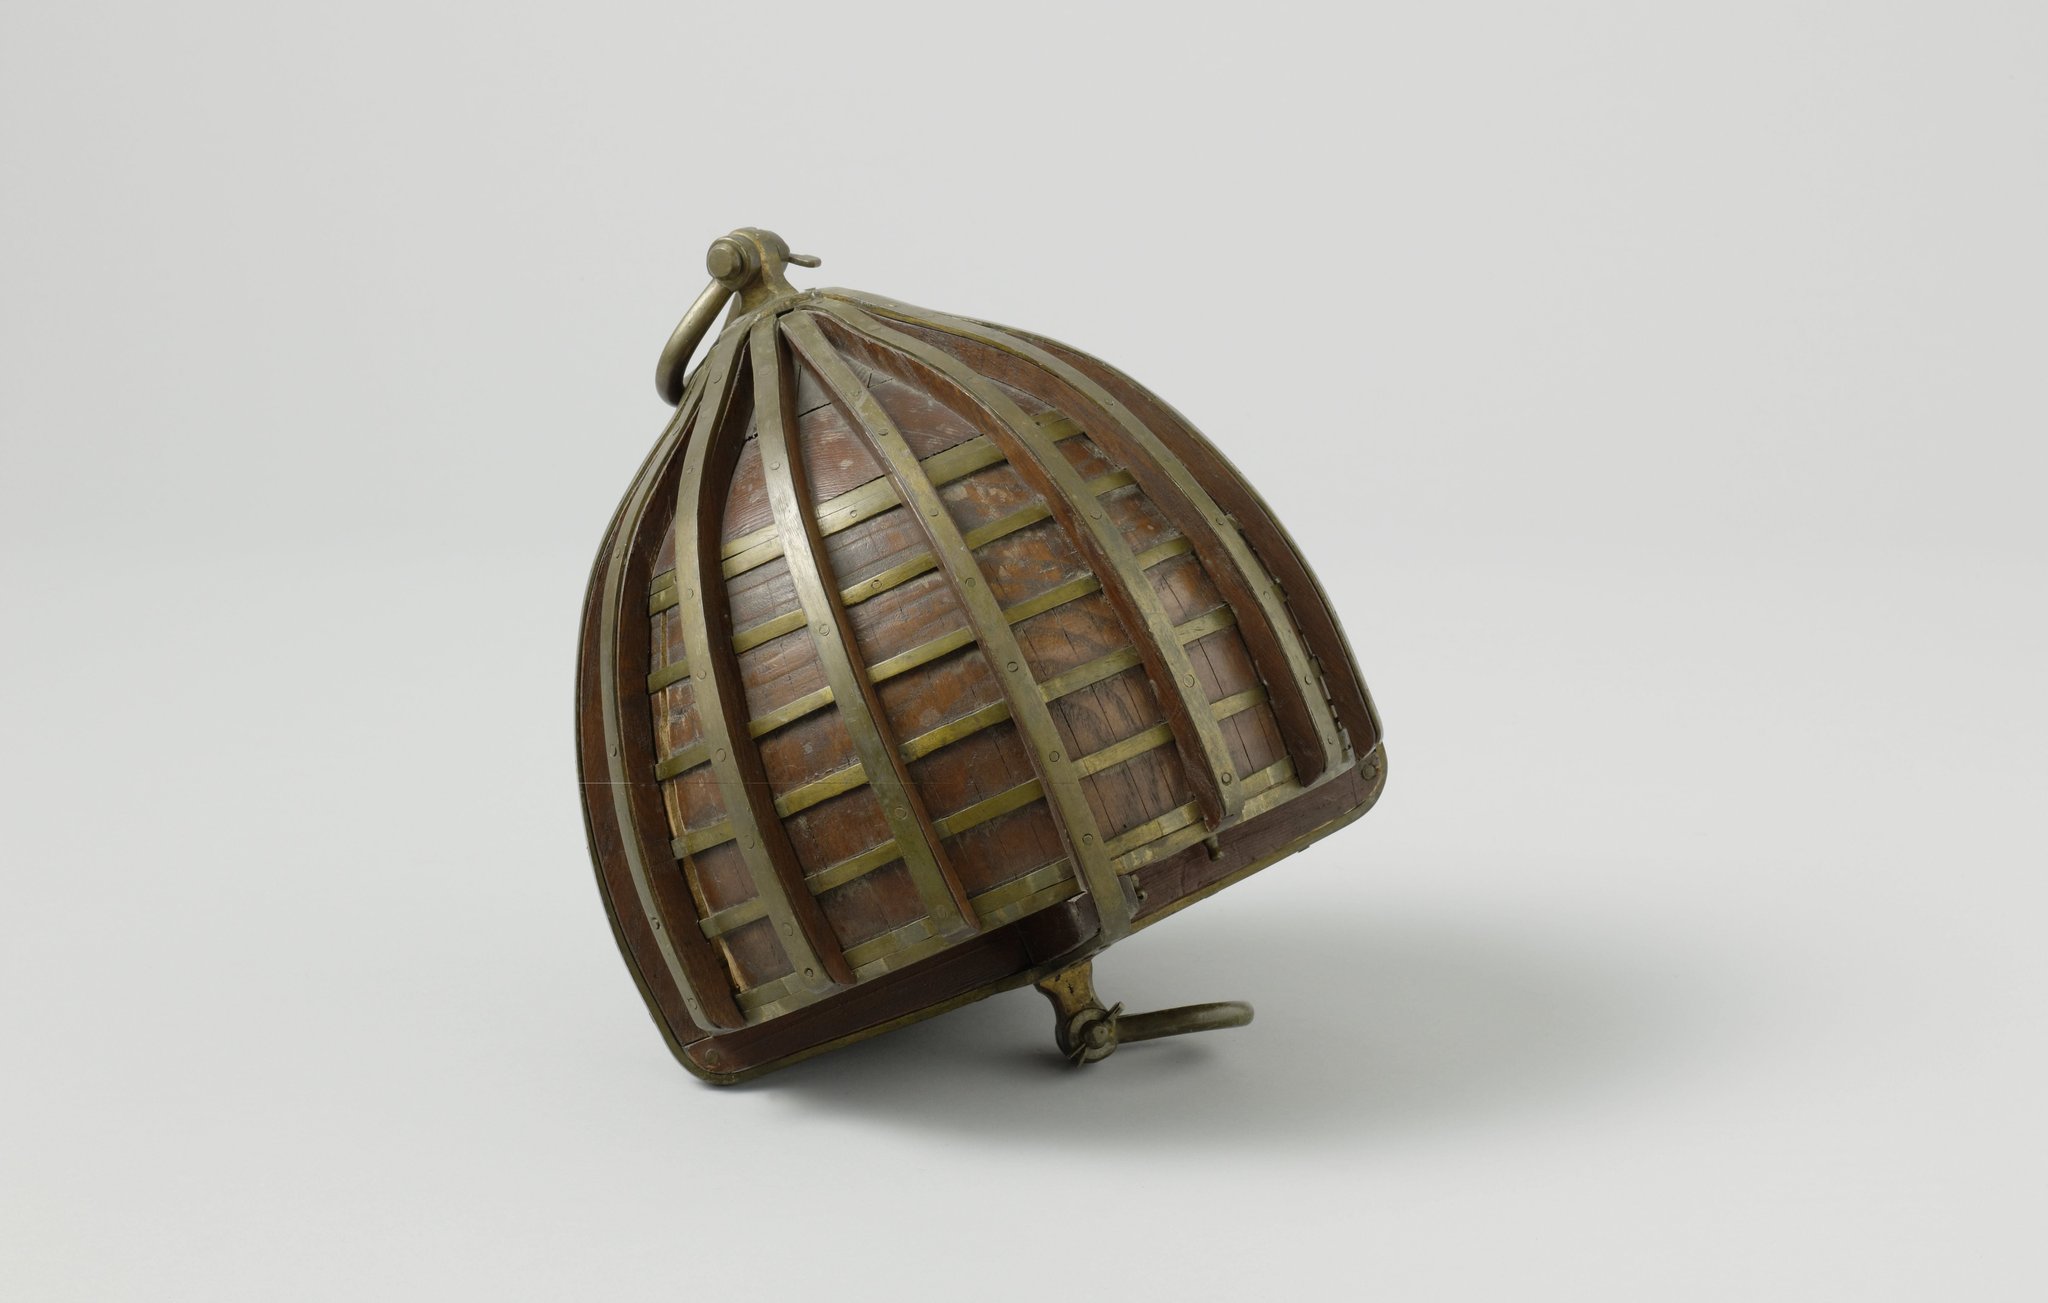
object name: demonstration model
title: Model of an Anchor Buoy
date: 1833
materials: brass, wood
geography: den helder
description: Uitgehold blokmodel van een ankerboei voor katankers. Het heeft een ui-vormig lichaam met de punt naar beneden en een platte bovenkant; het wordt bijeengehouden door hoepels, waarover aan de buitenkant de spanten lopen. Twee hoofdspanten lopen door over de platte bovenkant, waar zij een kruis vormen. Zowel boven als onder is een harpsluiting aangebracht. Door een mangat kan men de binnenkant bekijken, waarin twee dekken zijn aangebracht. Schaal 1:10 (afgeleid).